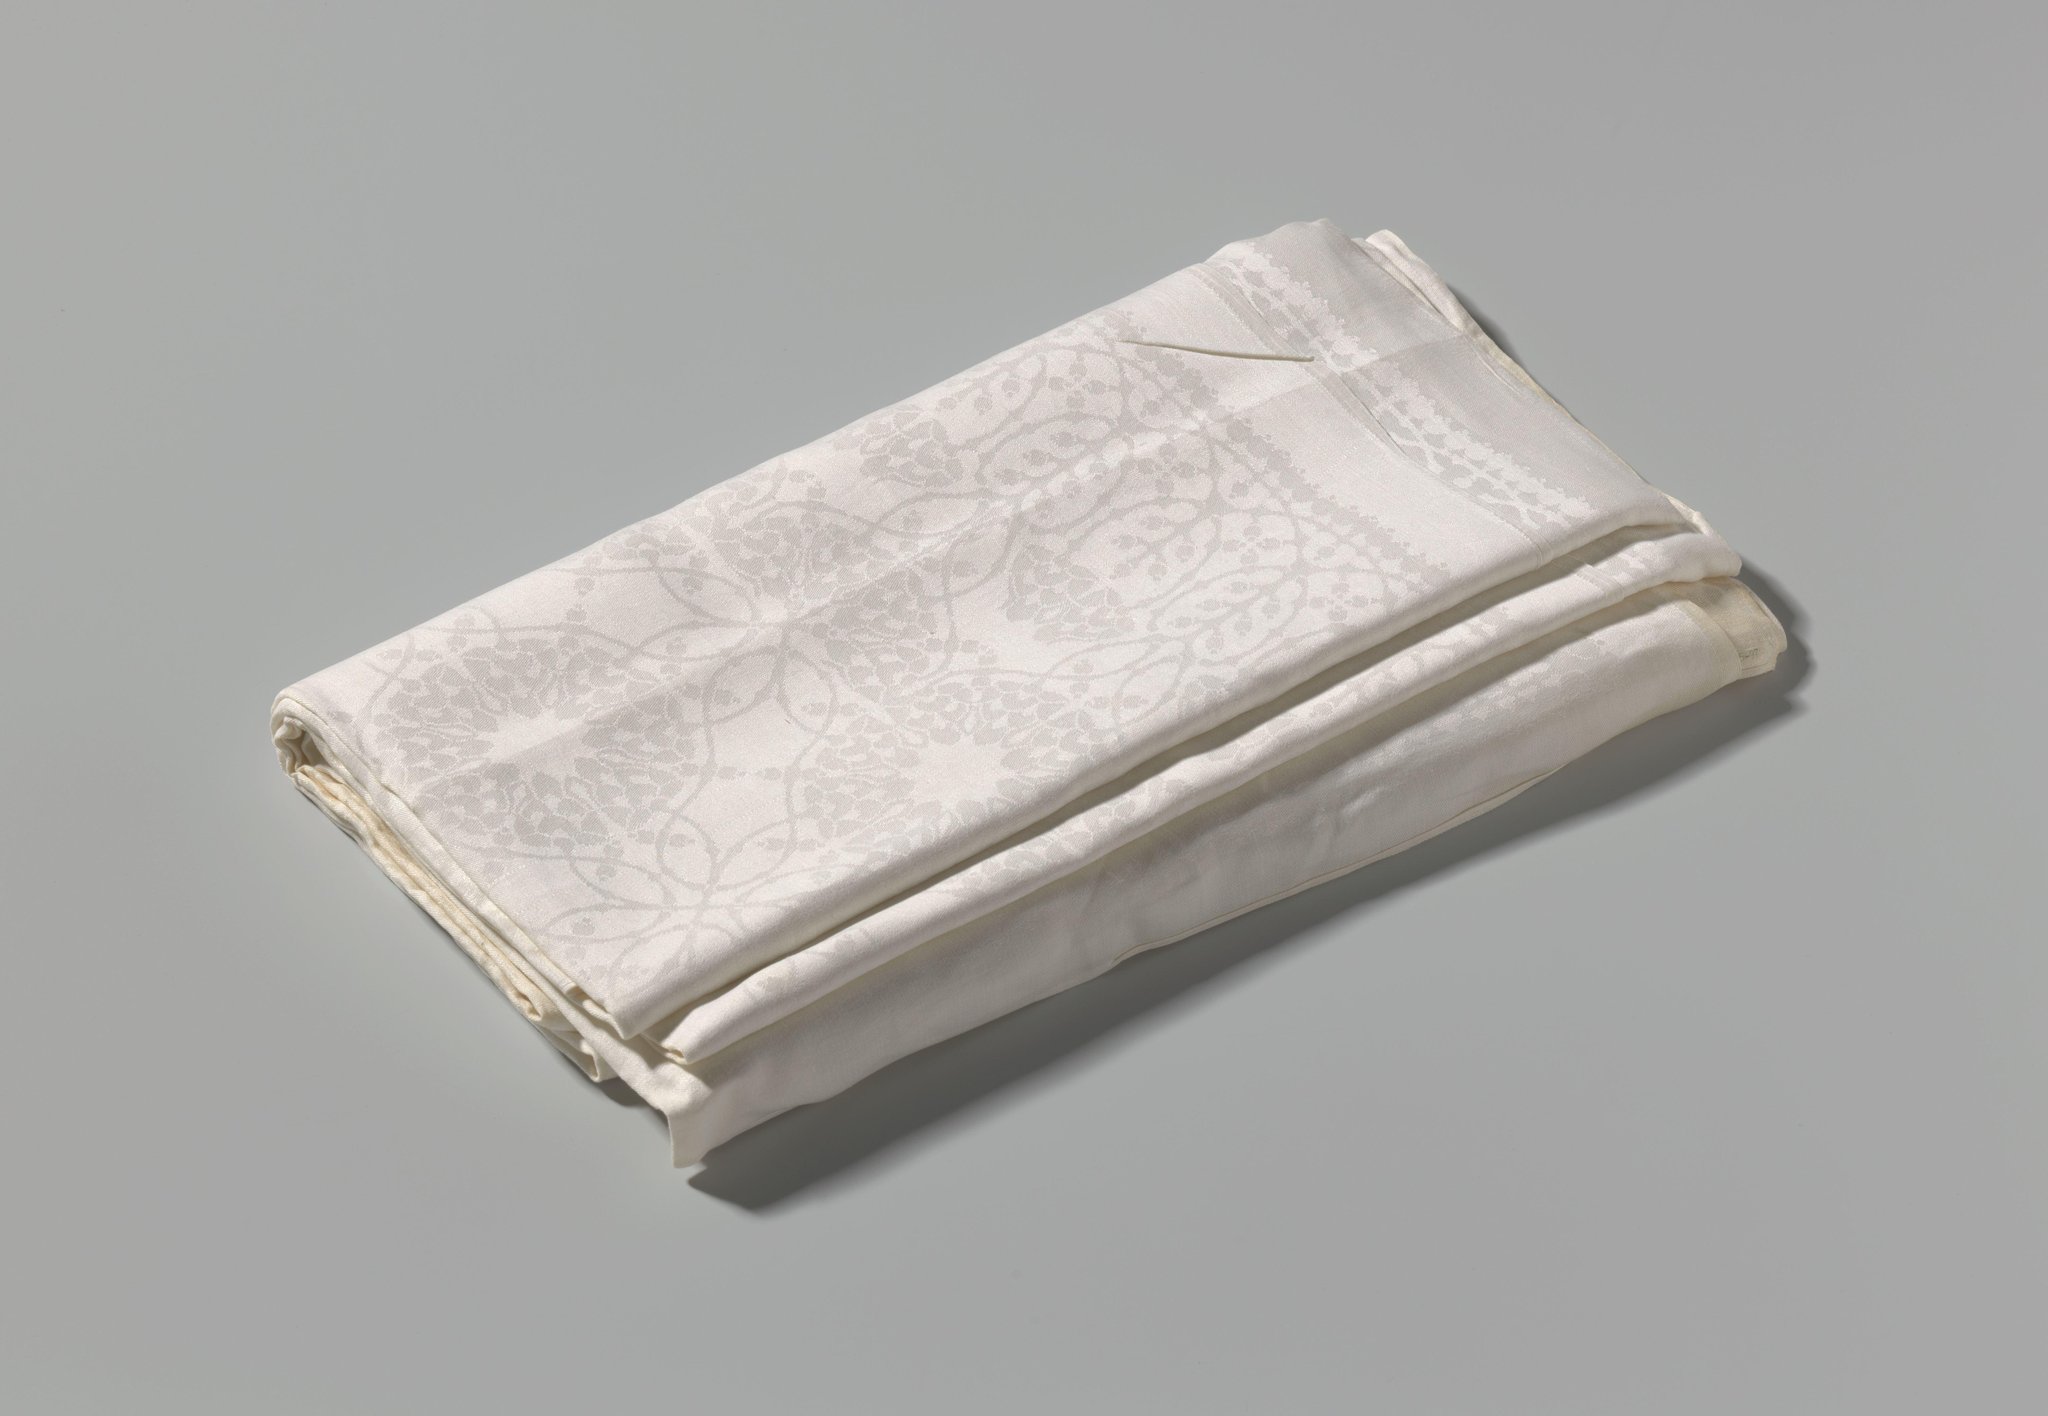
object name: woven material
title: Tafellaken van wit linnendamast met patroon "Hop"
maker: chris lebeau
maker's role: draughtsman, print maker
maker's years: 1878-1945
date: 1926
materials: linen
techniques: damask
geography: eindhoven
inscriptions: mark: ‘RL’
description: Tafellaken van wit linnendamast met patroon "Hop" (dessinnr. 612).